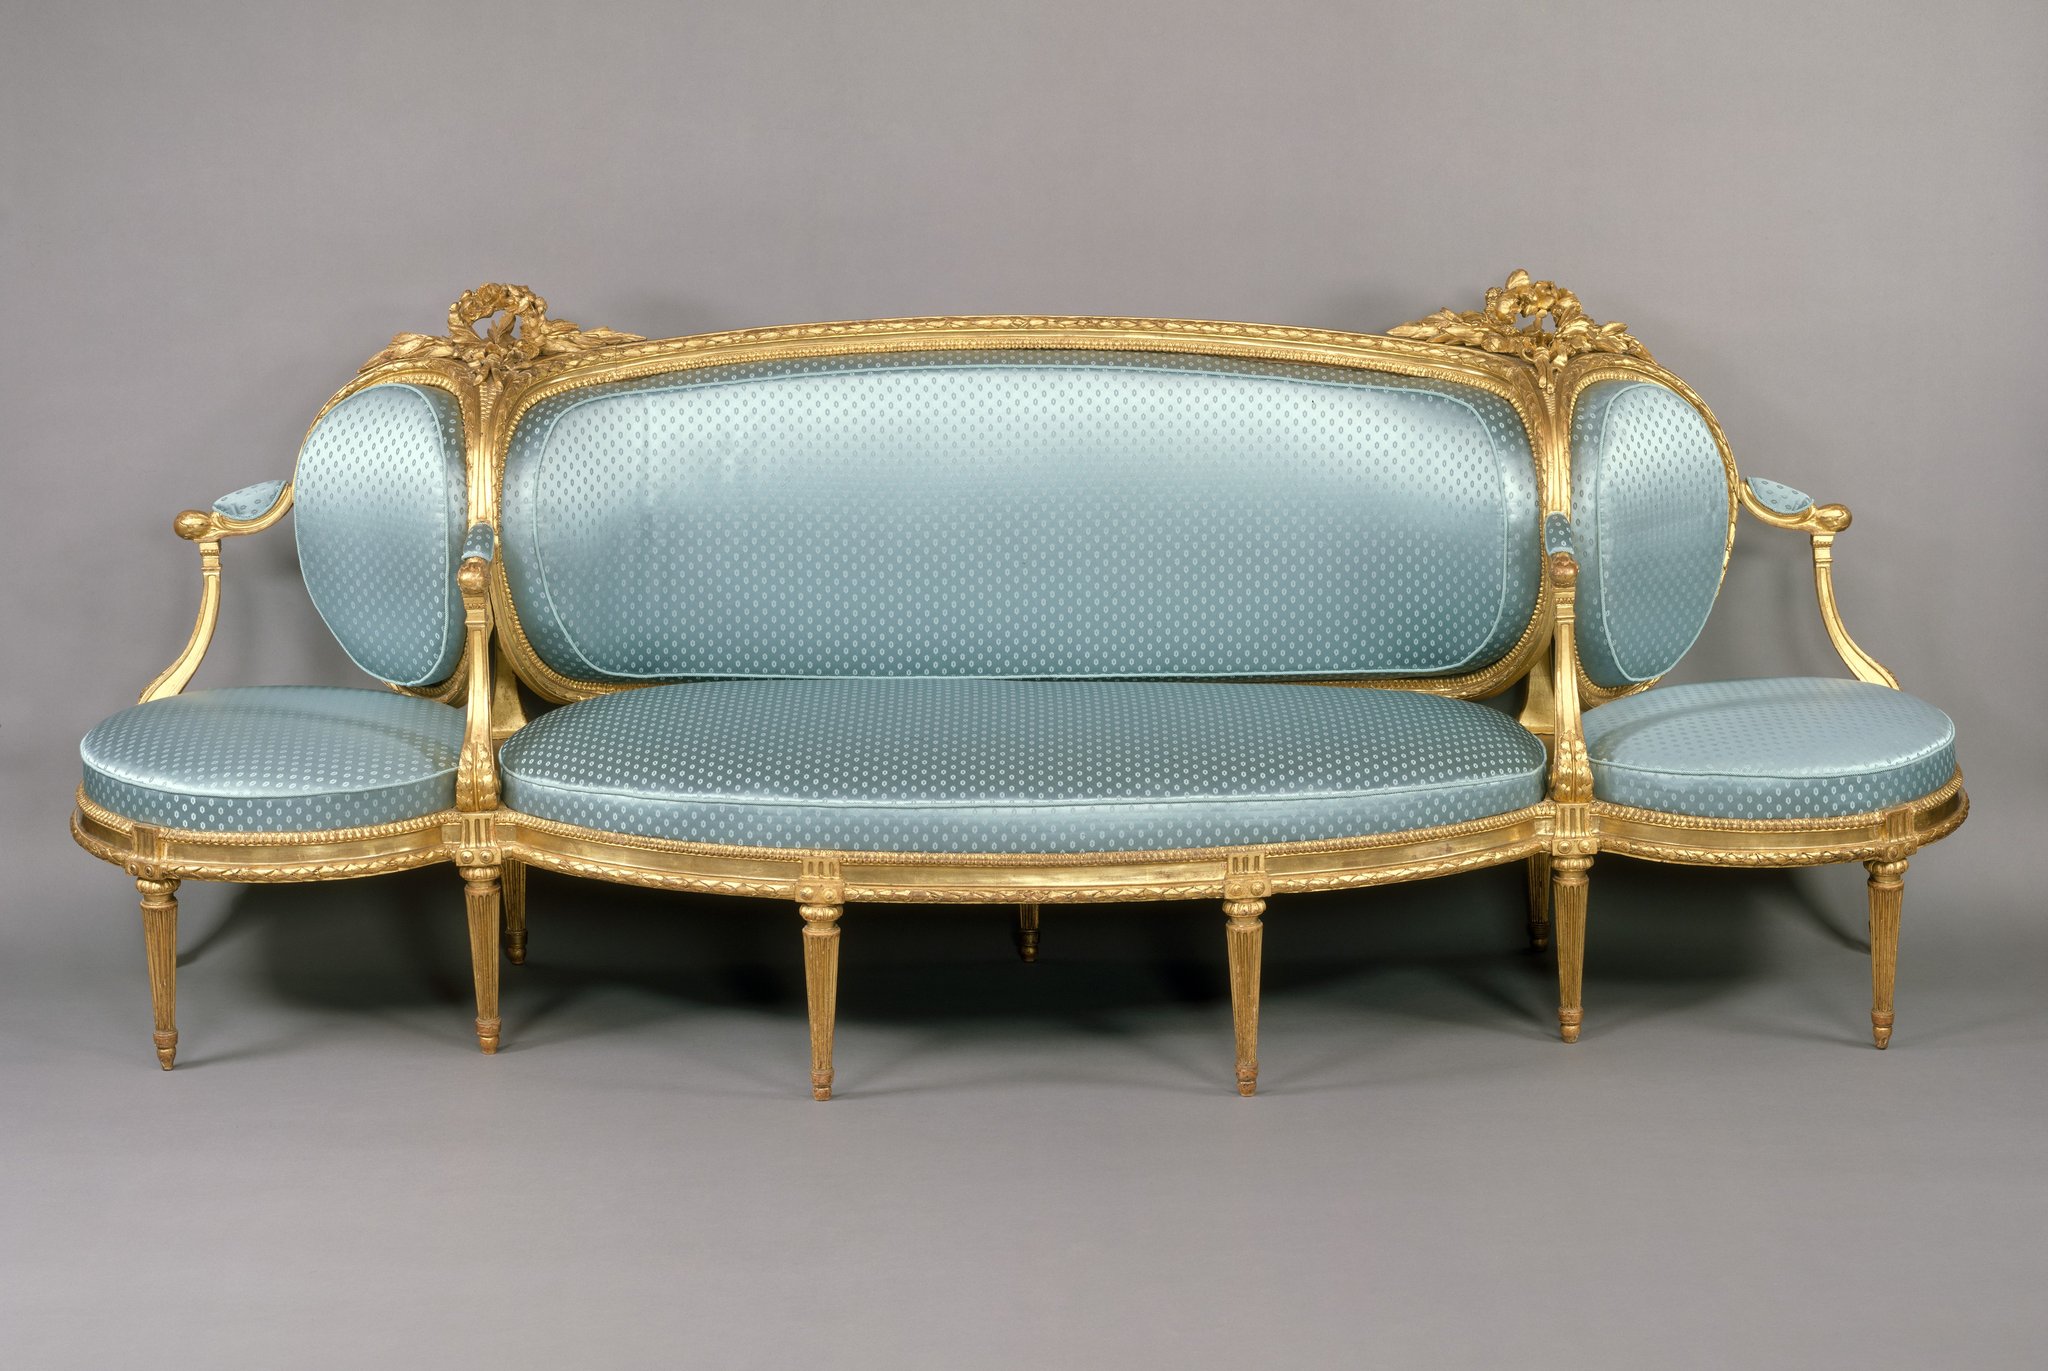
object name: sofa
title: Sofa (canapé à confidents)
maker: claude i sené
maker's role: maker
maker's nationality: french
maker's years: 1724-1792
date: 1775-1780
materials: wood, silk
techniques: carving, gilding